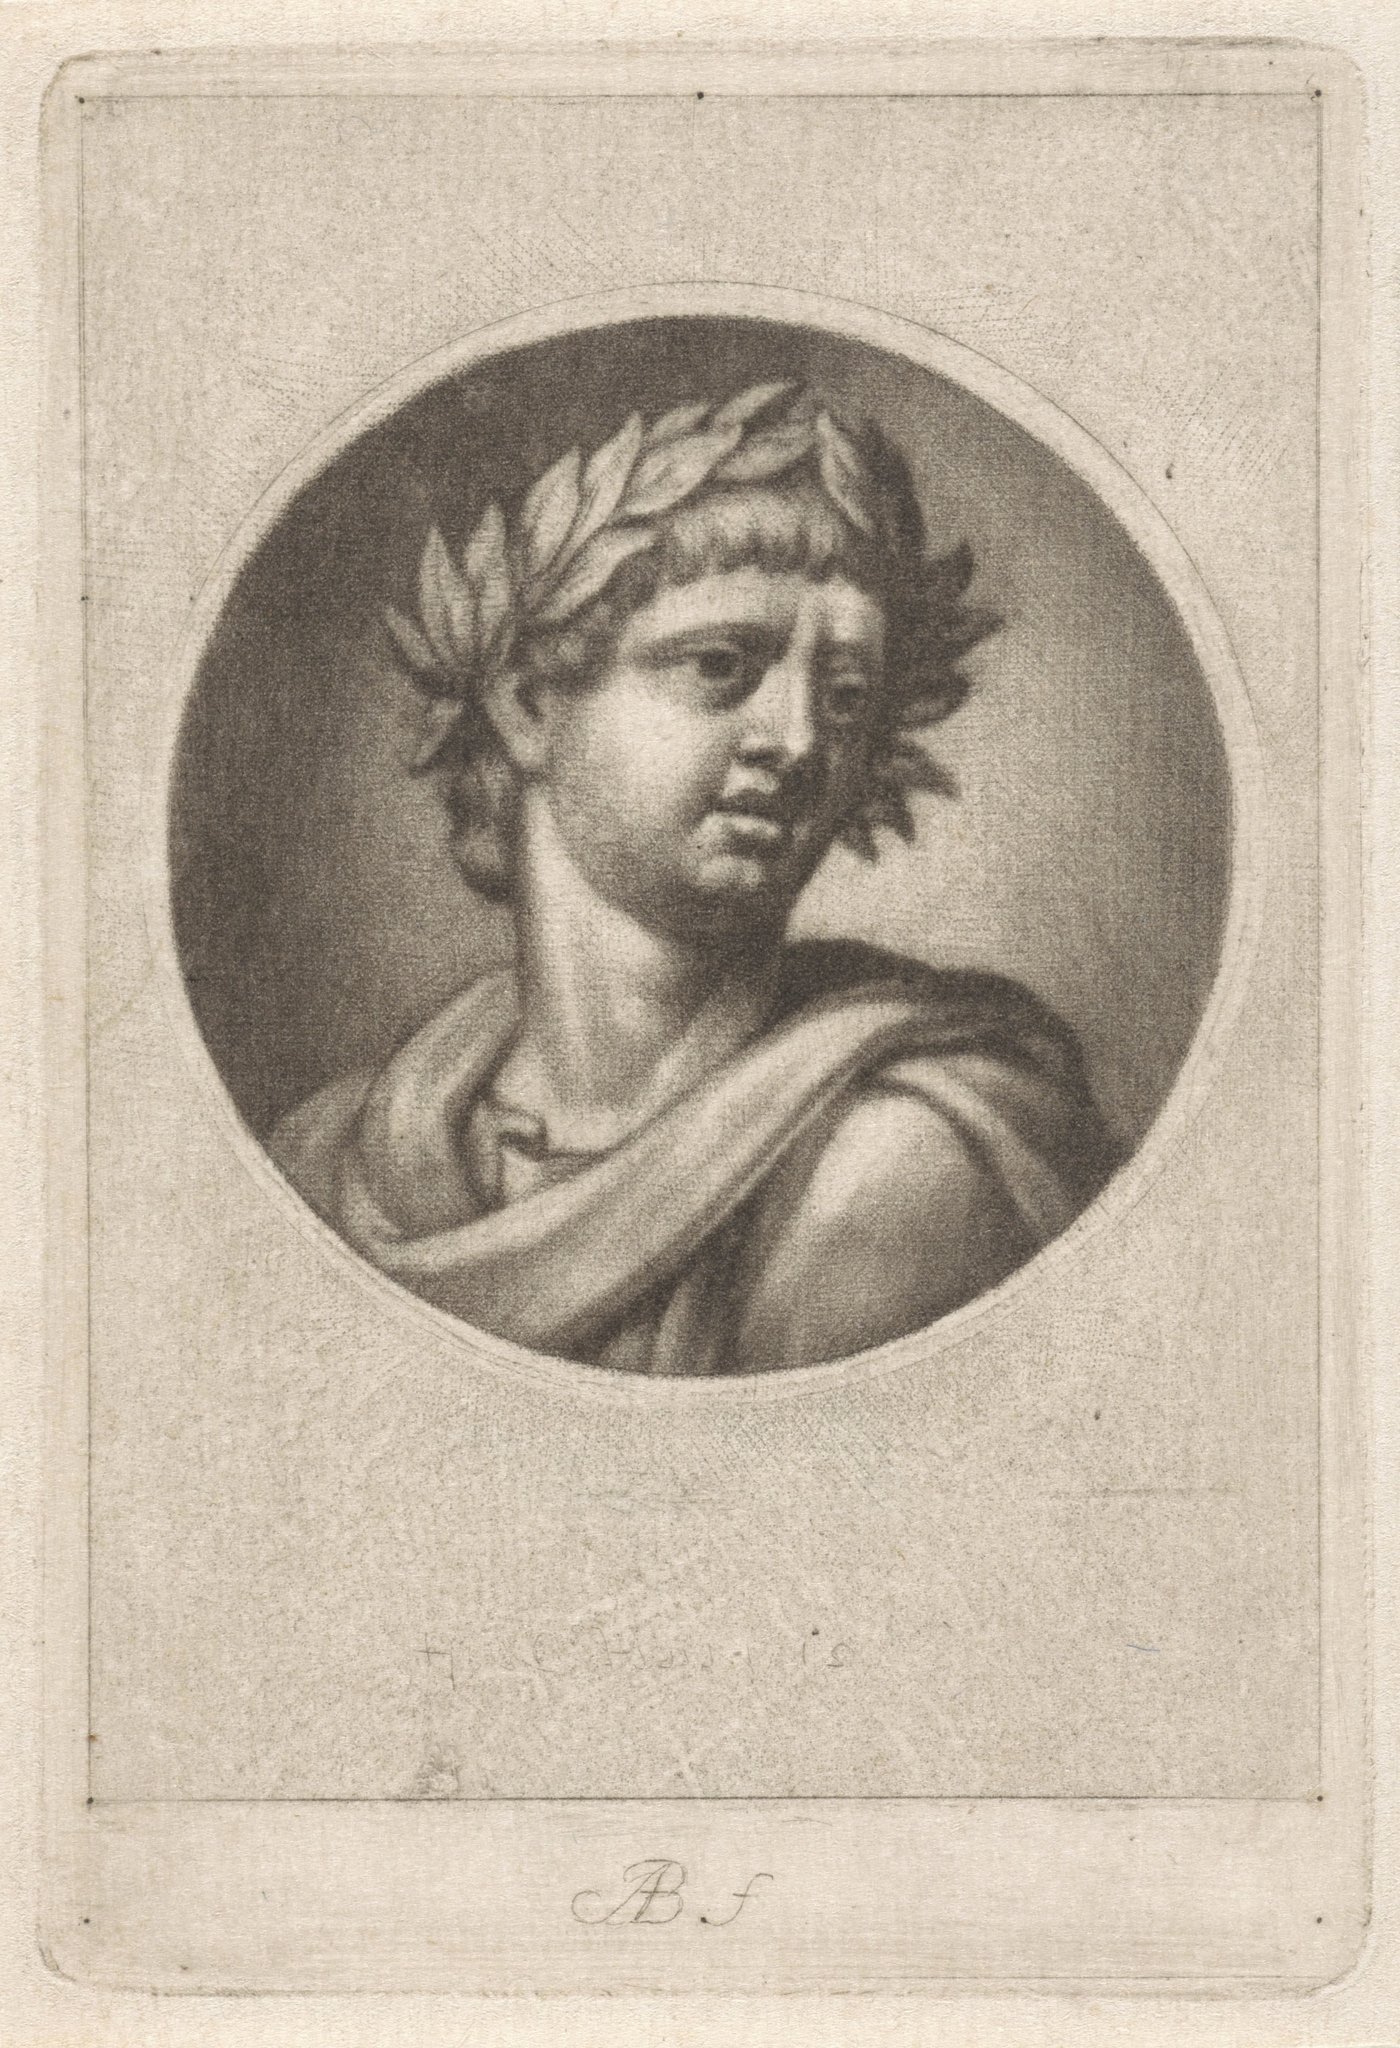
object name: print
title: Buste van een jonge man met lauwerkrans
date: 1652-1690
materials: paper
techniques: engraving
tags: crowning with laurel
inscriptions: collector's mark: Lugt 240